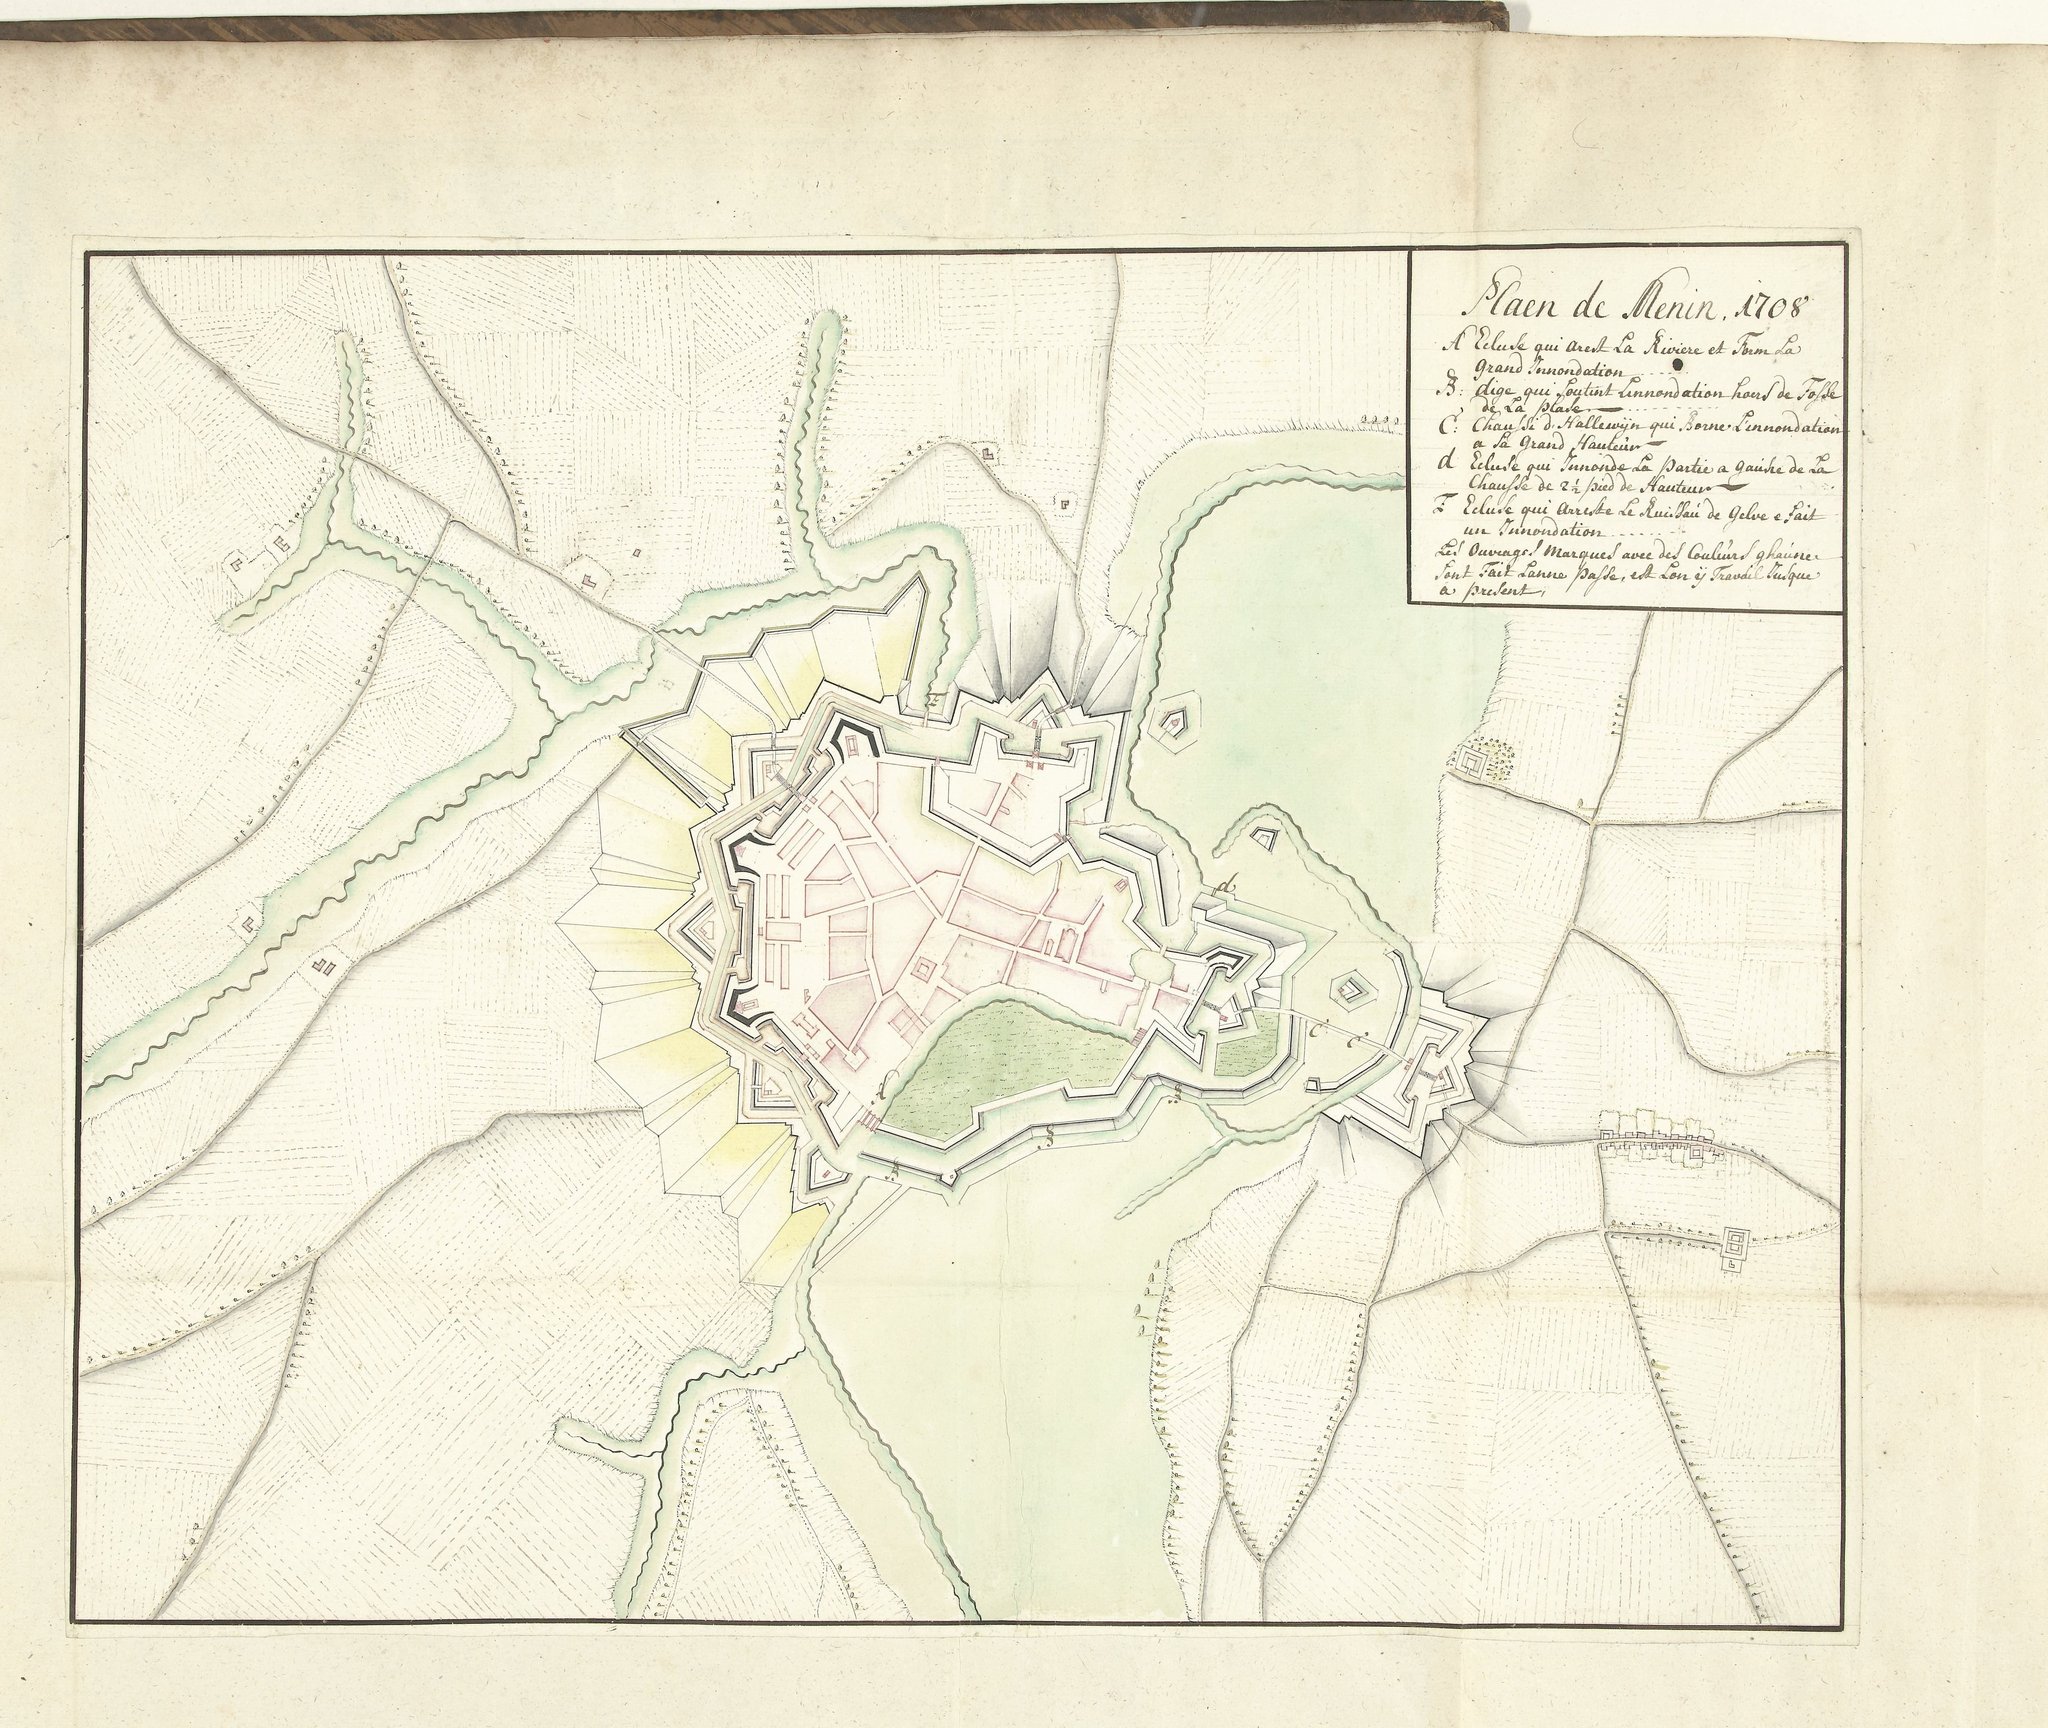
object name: map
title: Plaen de Menin, 1708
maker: samuel du ry de champdoré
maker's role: draughtsman, engineer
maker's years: 1651-1729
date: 1708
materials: paper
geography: netherlands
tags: fortress, flood, maps of cities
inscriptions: date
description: Plattegrond van de versterkingen en inundaties om de stad Menen, 1708. Rechtsboven de titel en legenda A-E in het Frans. Onderdeel van een verzameling getekende plannen van versterkte plaatsen in Nederland en omringende landen ten tijde van de Spaanse Successieoorlog (deel D).